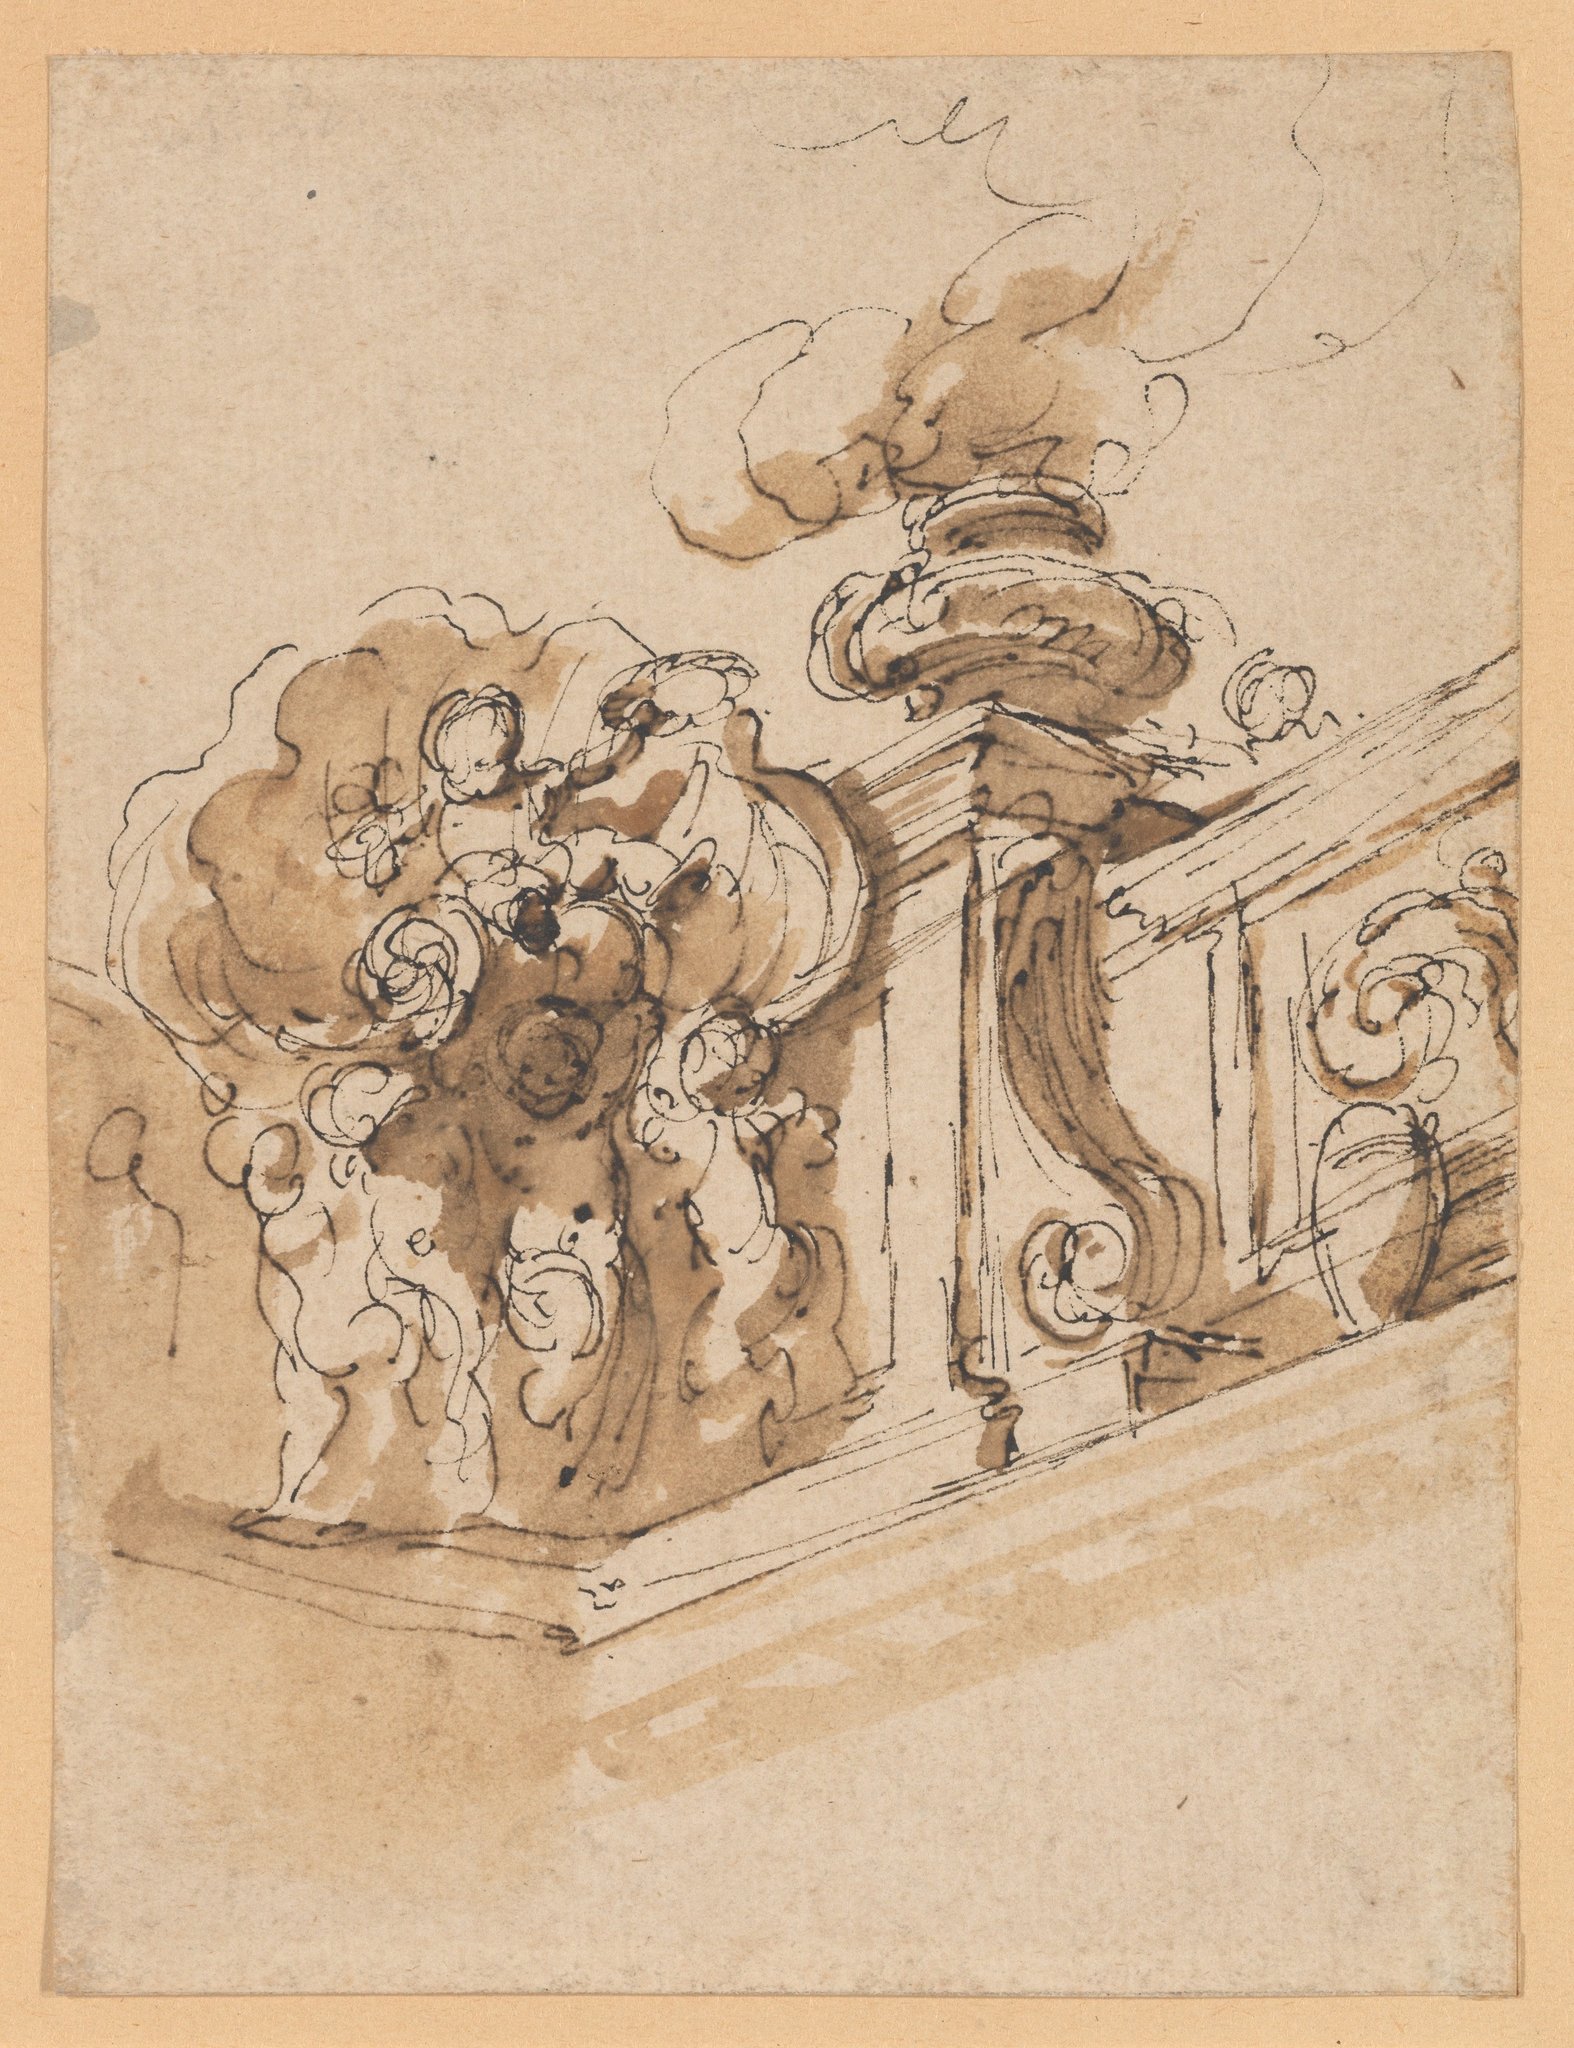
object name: drawing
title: Design for Interior Corner of a Frieze or a Stairwell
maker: anonymous, italian, 17th or 18th century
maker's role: artist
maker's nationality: italian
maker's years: 1600-1799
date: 1650-1750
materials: graphite, ink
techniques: pen, wash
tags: infants